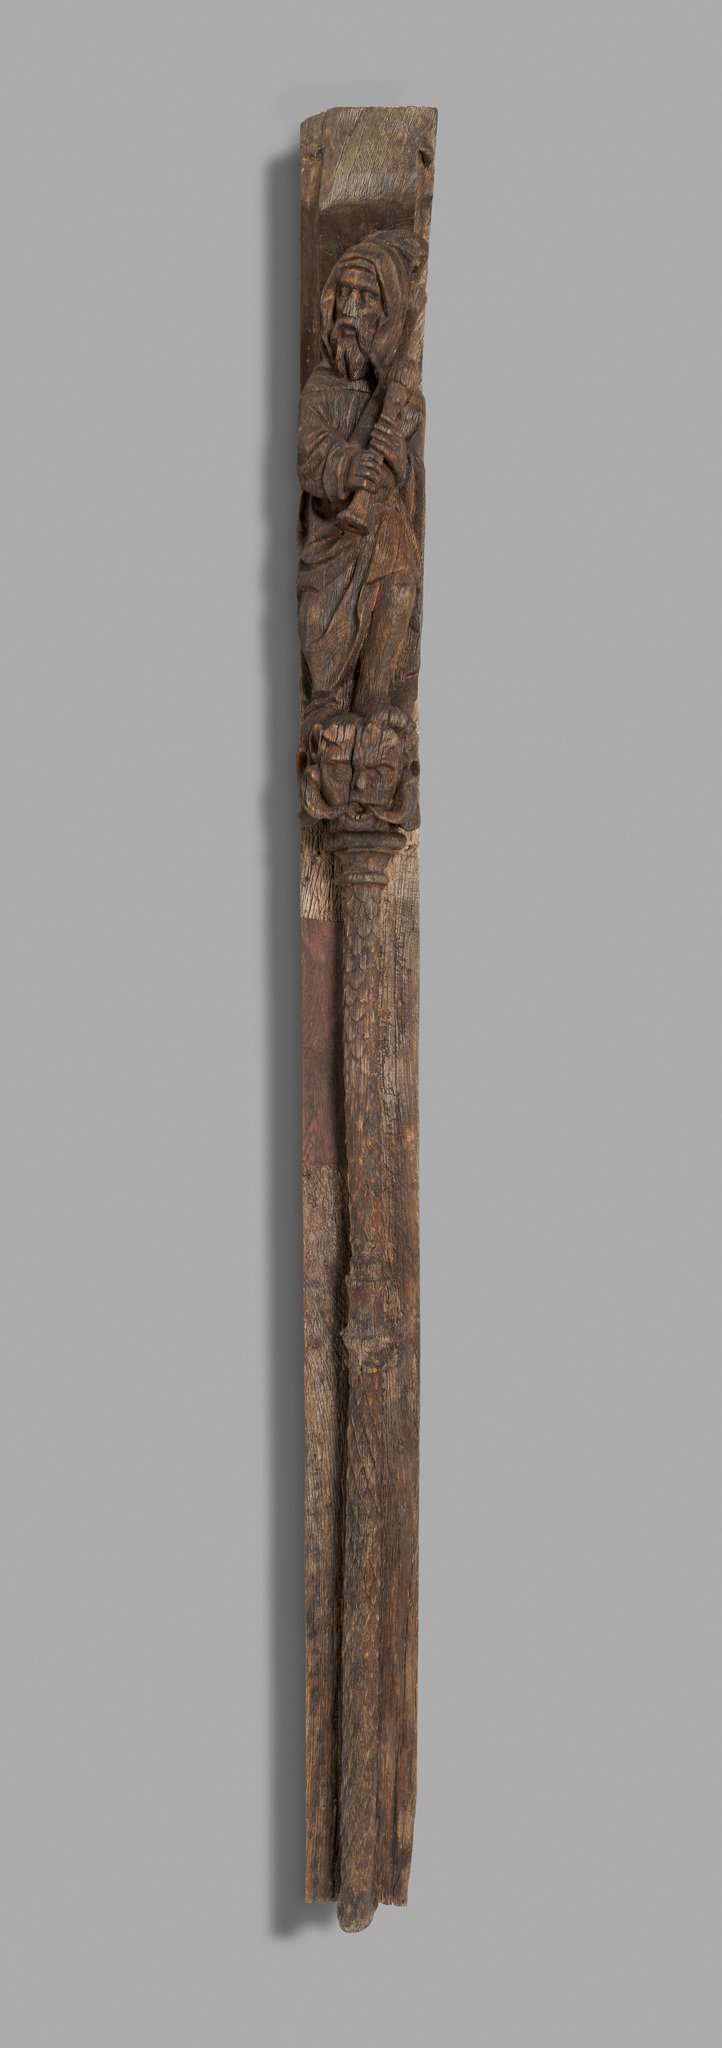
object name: architectural support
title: Architectural Support with a Bagpiper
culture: french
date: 1524-1525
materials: wood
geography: england